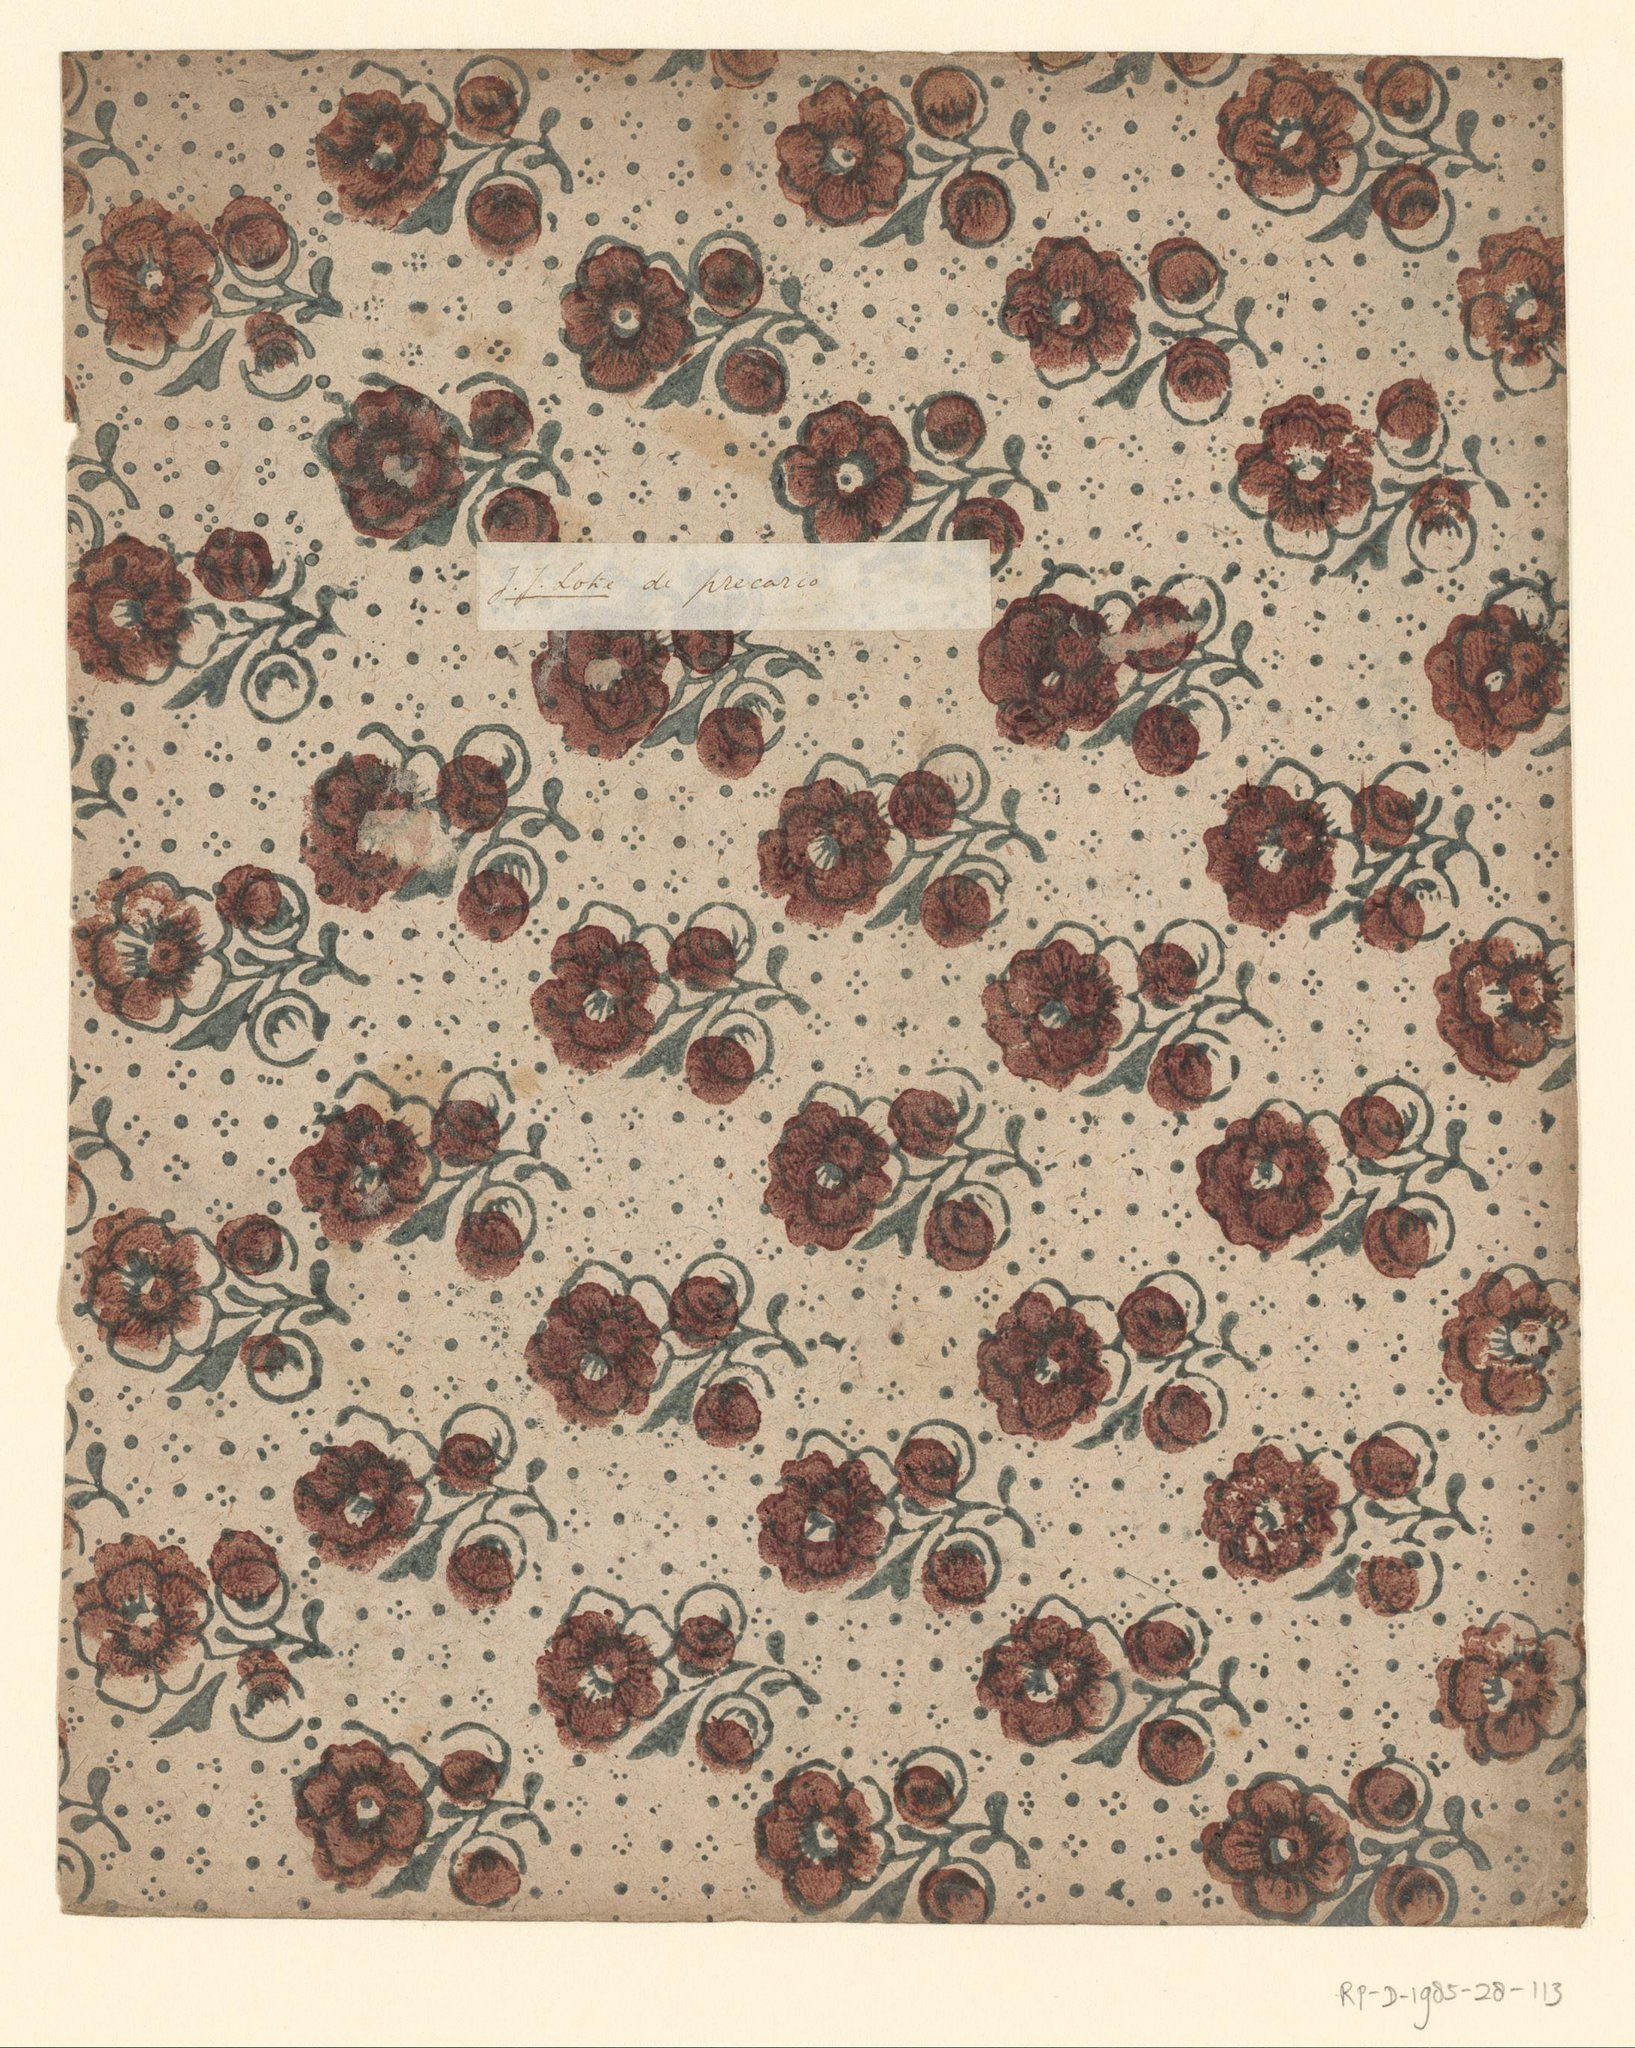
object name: printed paper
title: Blad met strooipatroon van bloemen in een puntenfond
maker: Anonymous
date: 1750-1900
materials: paper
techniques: printing block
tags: ornament derived from plant forms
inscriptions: collector's mark: Lugt 2228, collector's mark: Lugt 2760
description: Blad met strooipatroon van bloemen in een puntenfond. Met etiket met opschrift: 'J.J. Loke de precario'. Helft van een omslag.